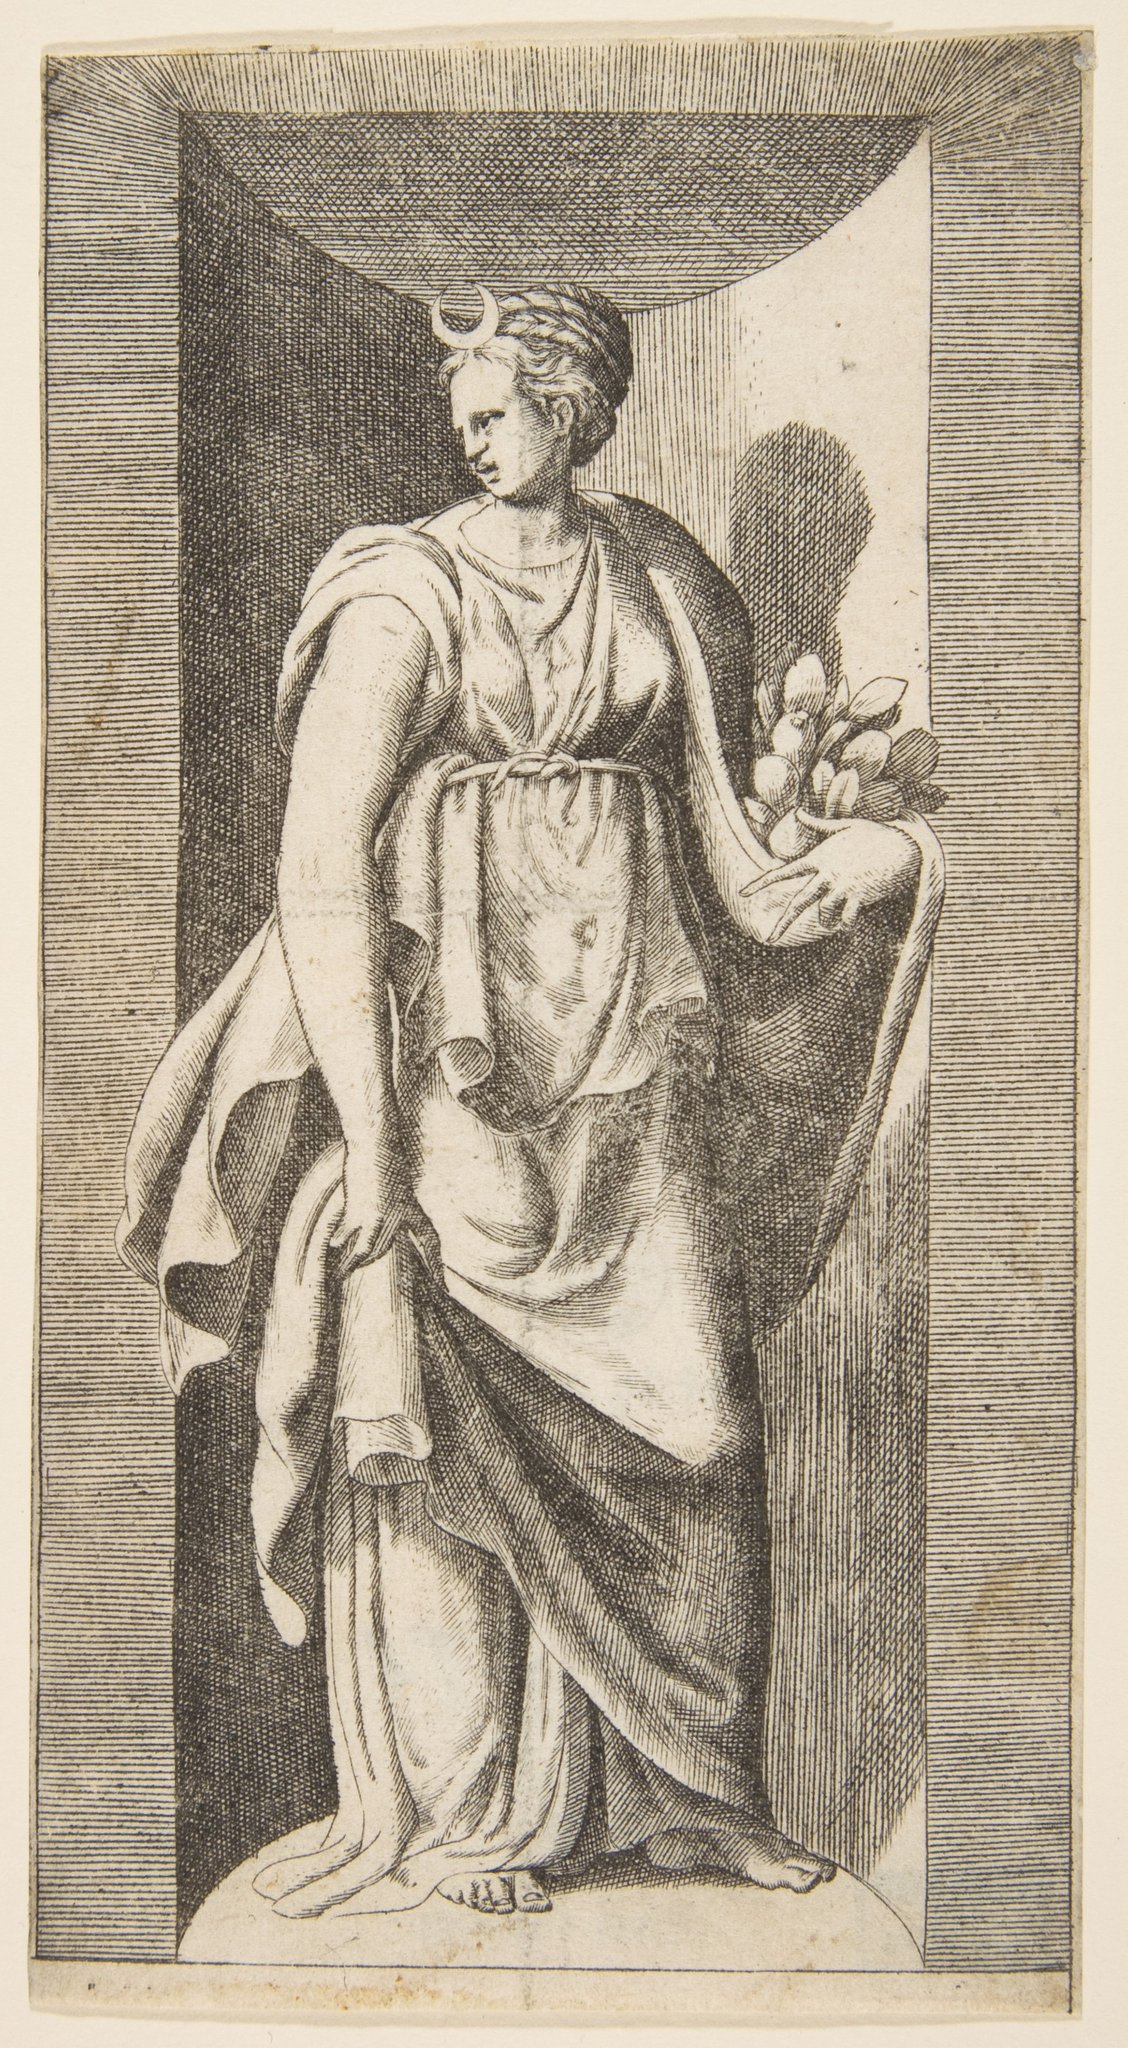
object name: print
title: Diana holding fruit in her left hand standing within a niche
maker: giulio bonasone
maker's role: artist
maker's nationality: italian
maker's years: 1510-1576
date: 1531-1576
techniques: engraving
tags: fruit,diana